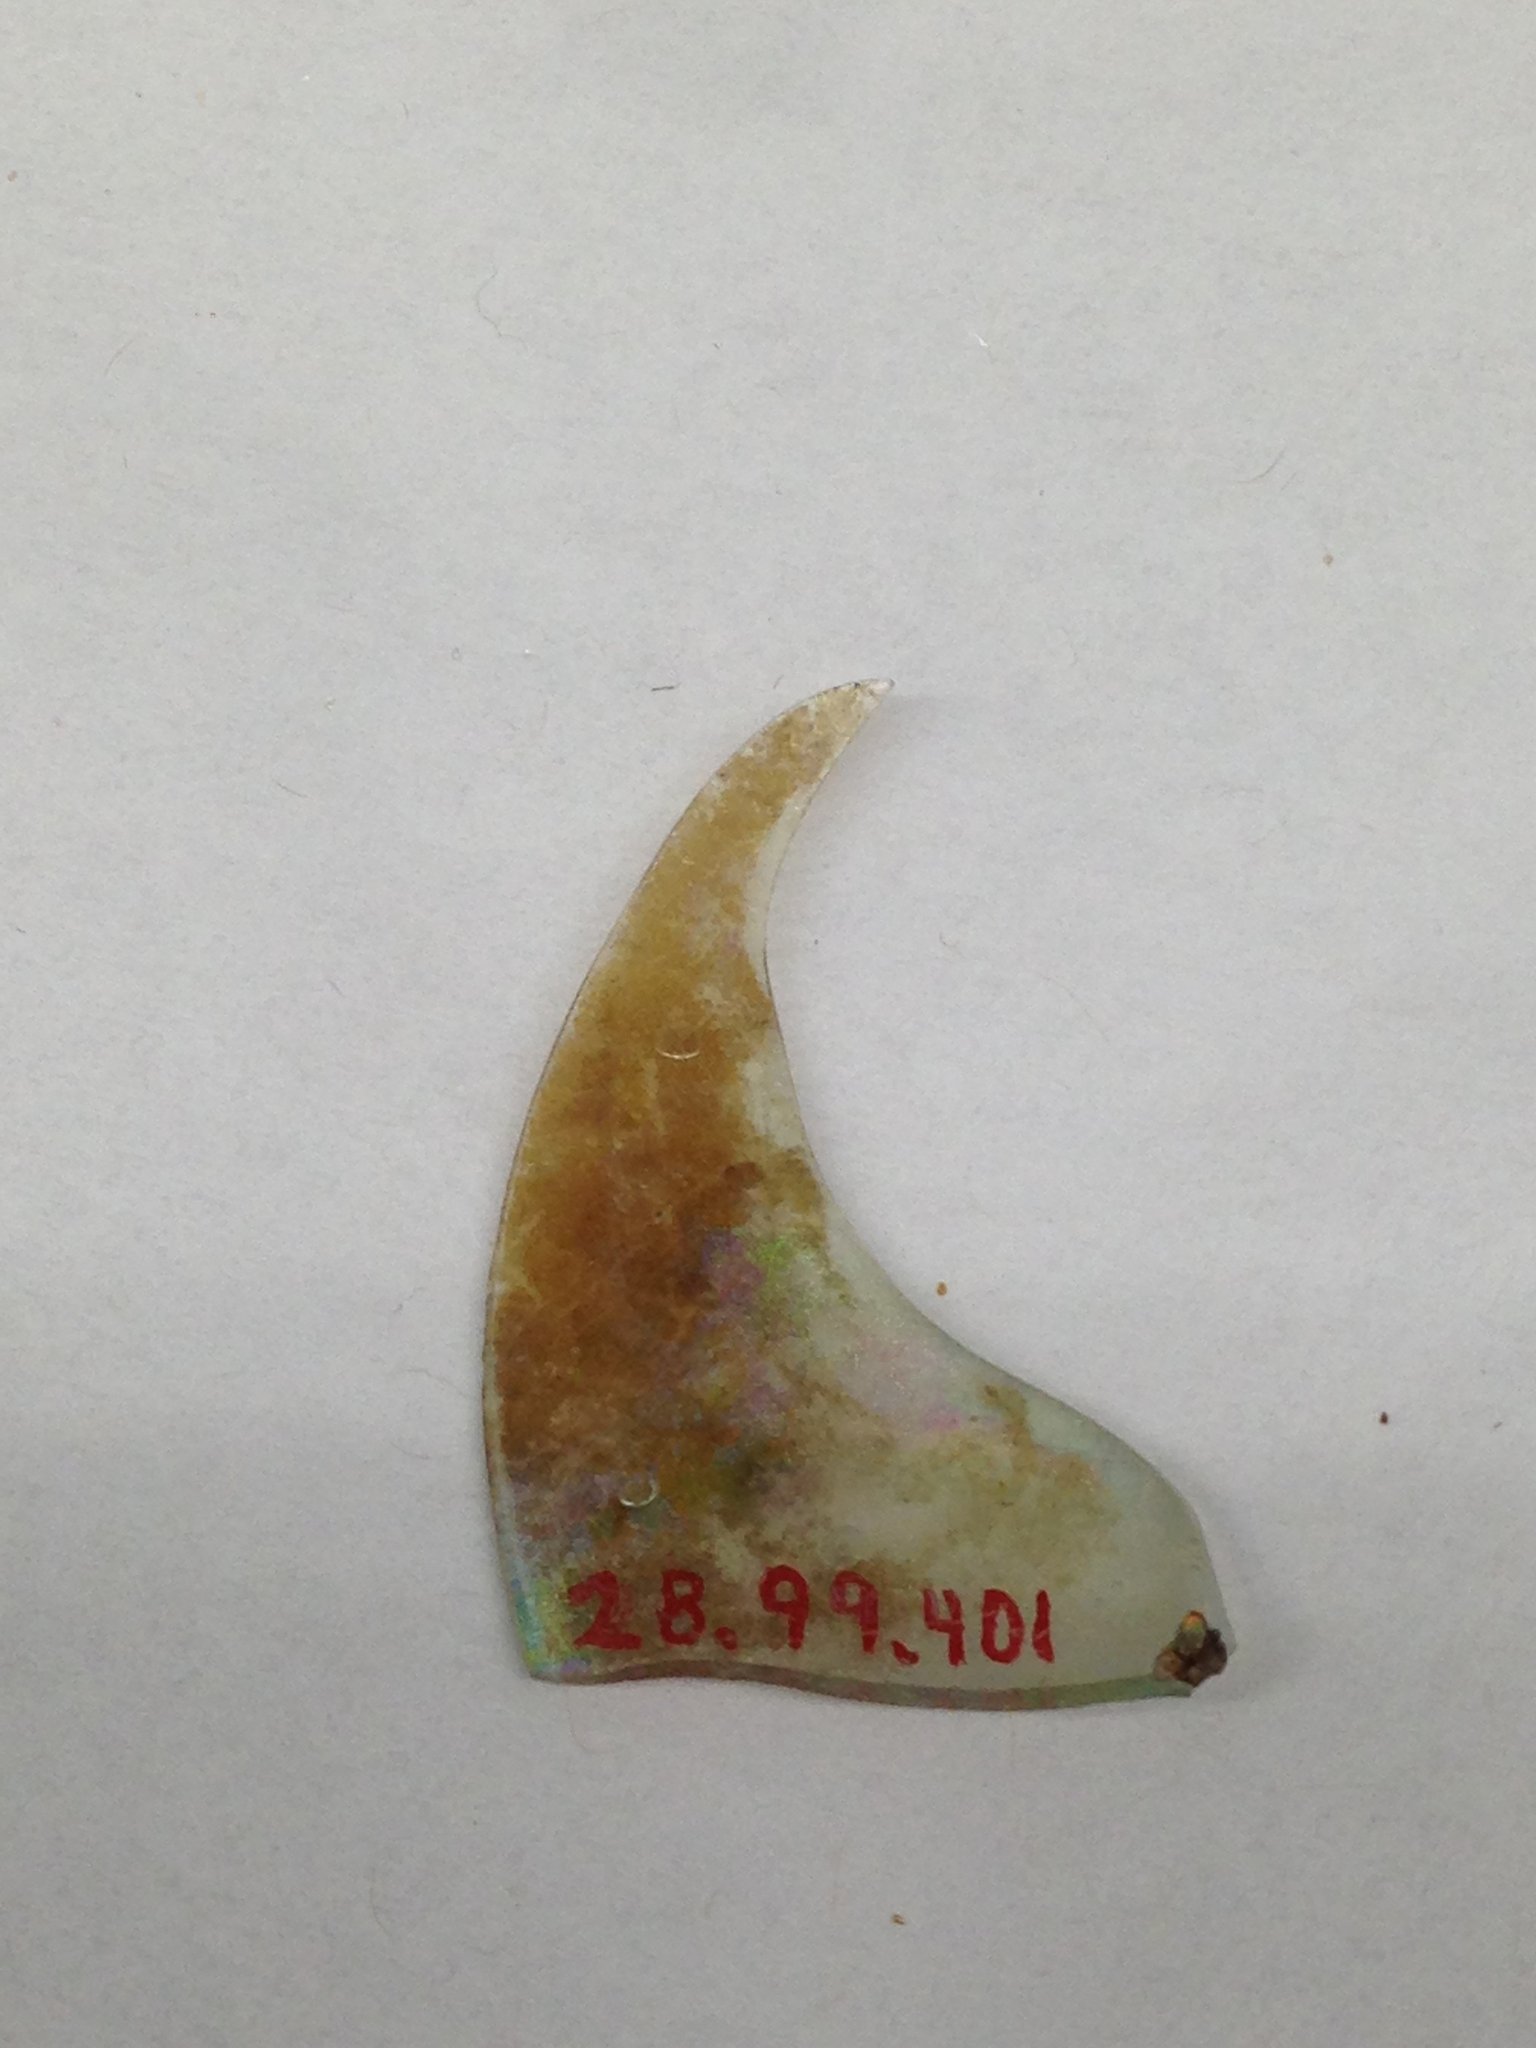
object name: fragment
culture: european or middle eastern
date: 1150-1250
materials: ceramic, glass